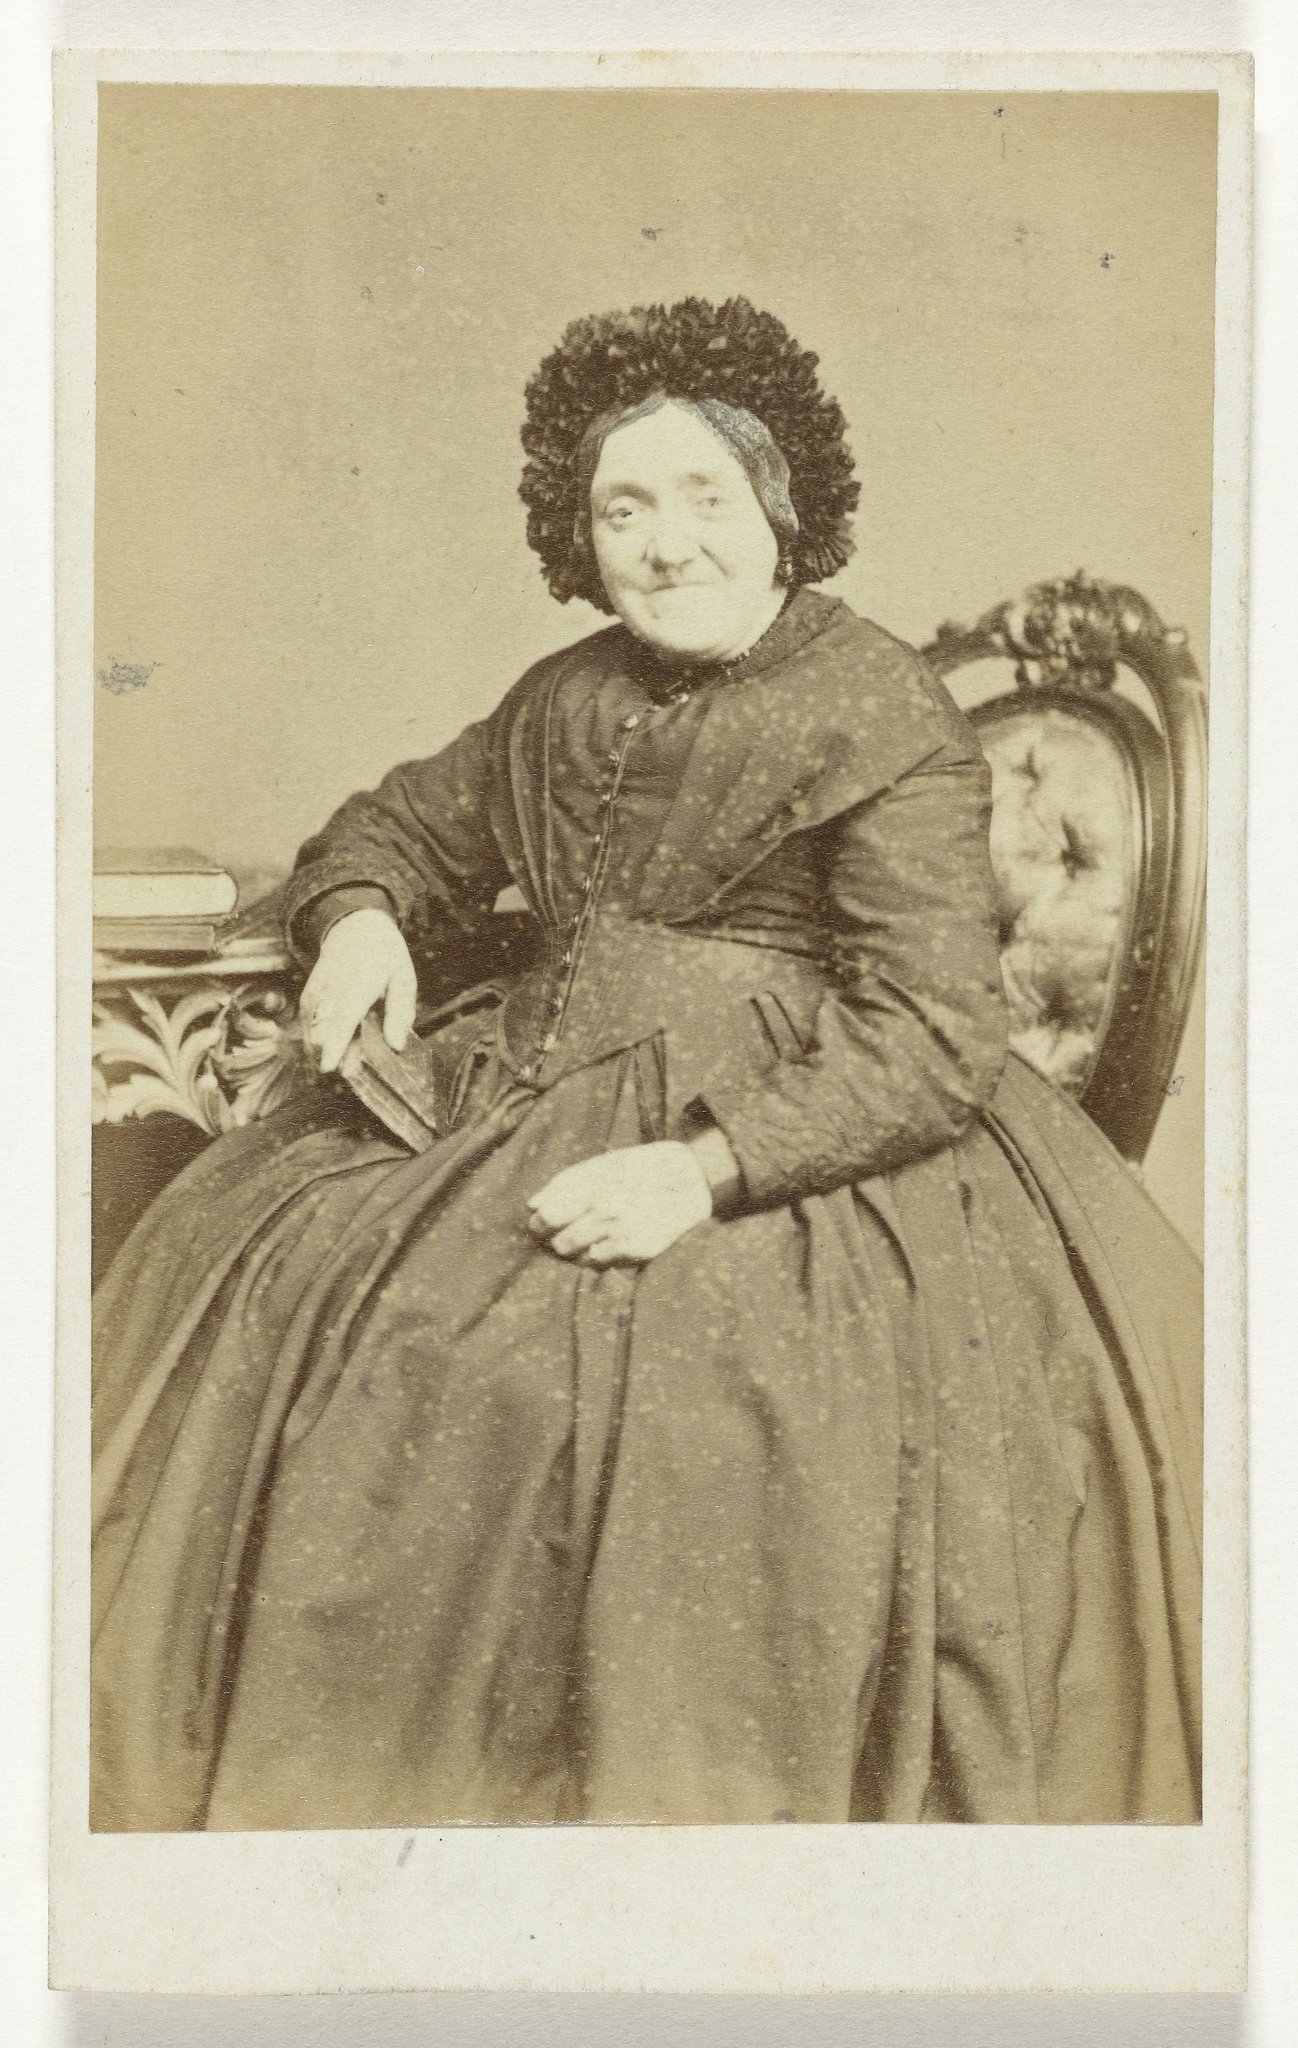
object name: photograph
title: Portret van een oudere vrouw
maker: peter carstensen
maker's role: fotograaf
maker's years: 1817-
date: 1860-1880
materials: cardboard, paper, photographic support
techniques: albumen print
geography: amsterdam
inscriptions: address: ‘PHOTOGRAFISCH ATELIER // P. CARSTENSEN // Nieuwendijk H 201 // AMSTERDAM // AMSTERDAM’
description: Portret van een oudere vrouw met een donkere muts op en een boekje in de hand, zittend naast een tafel.